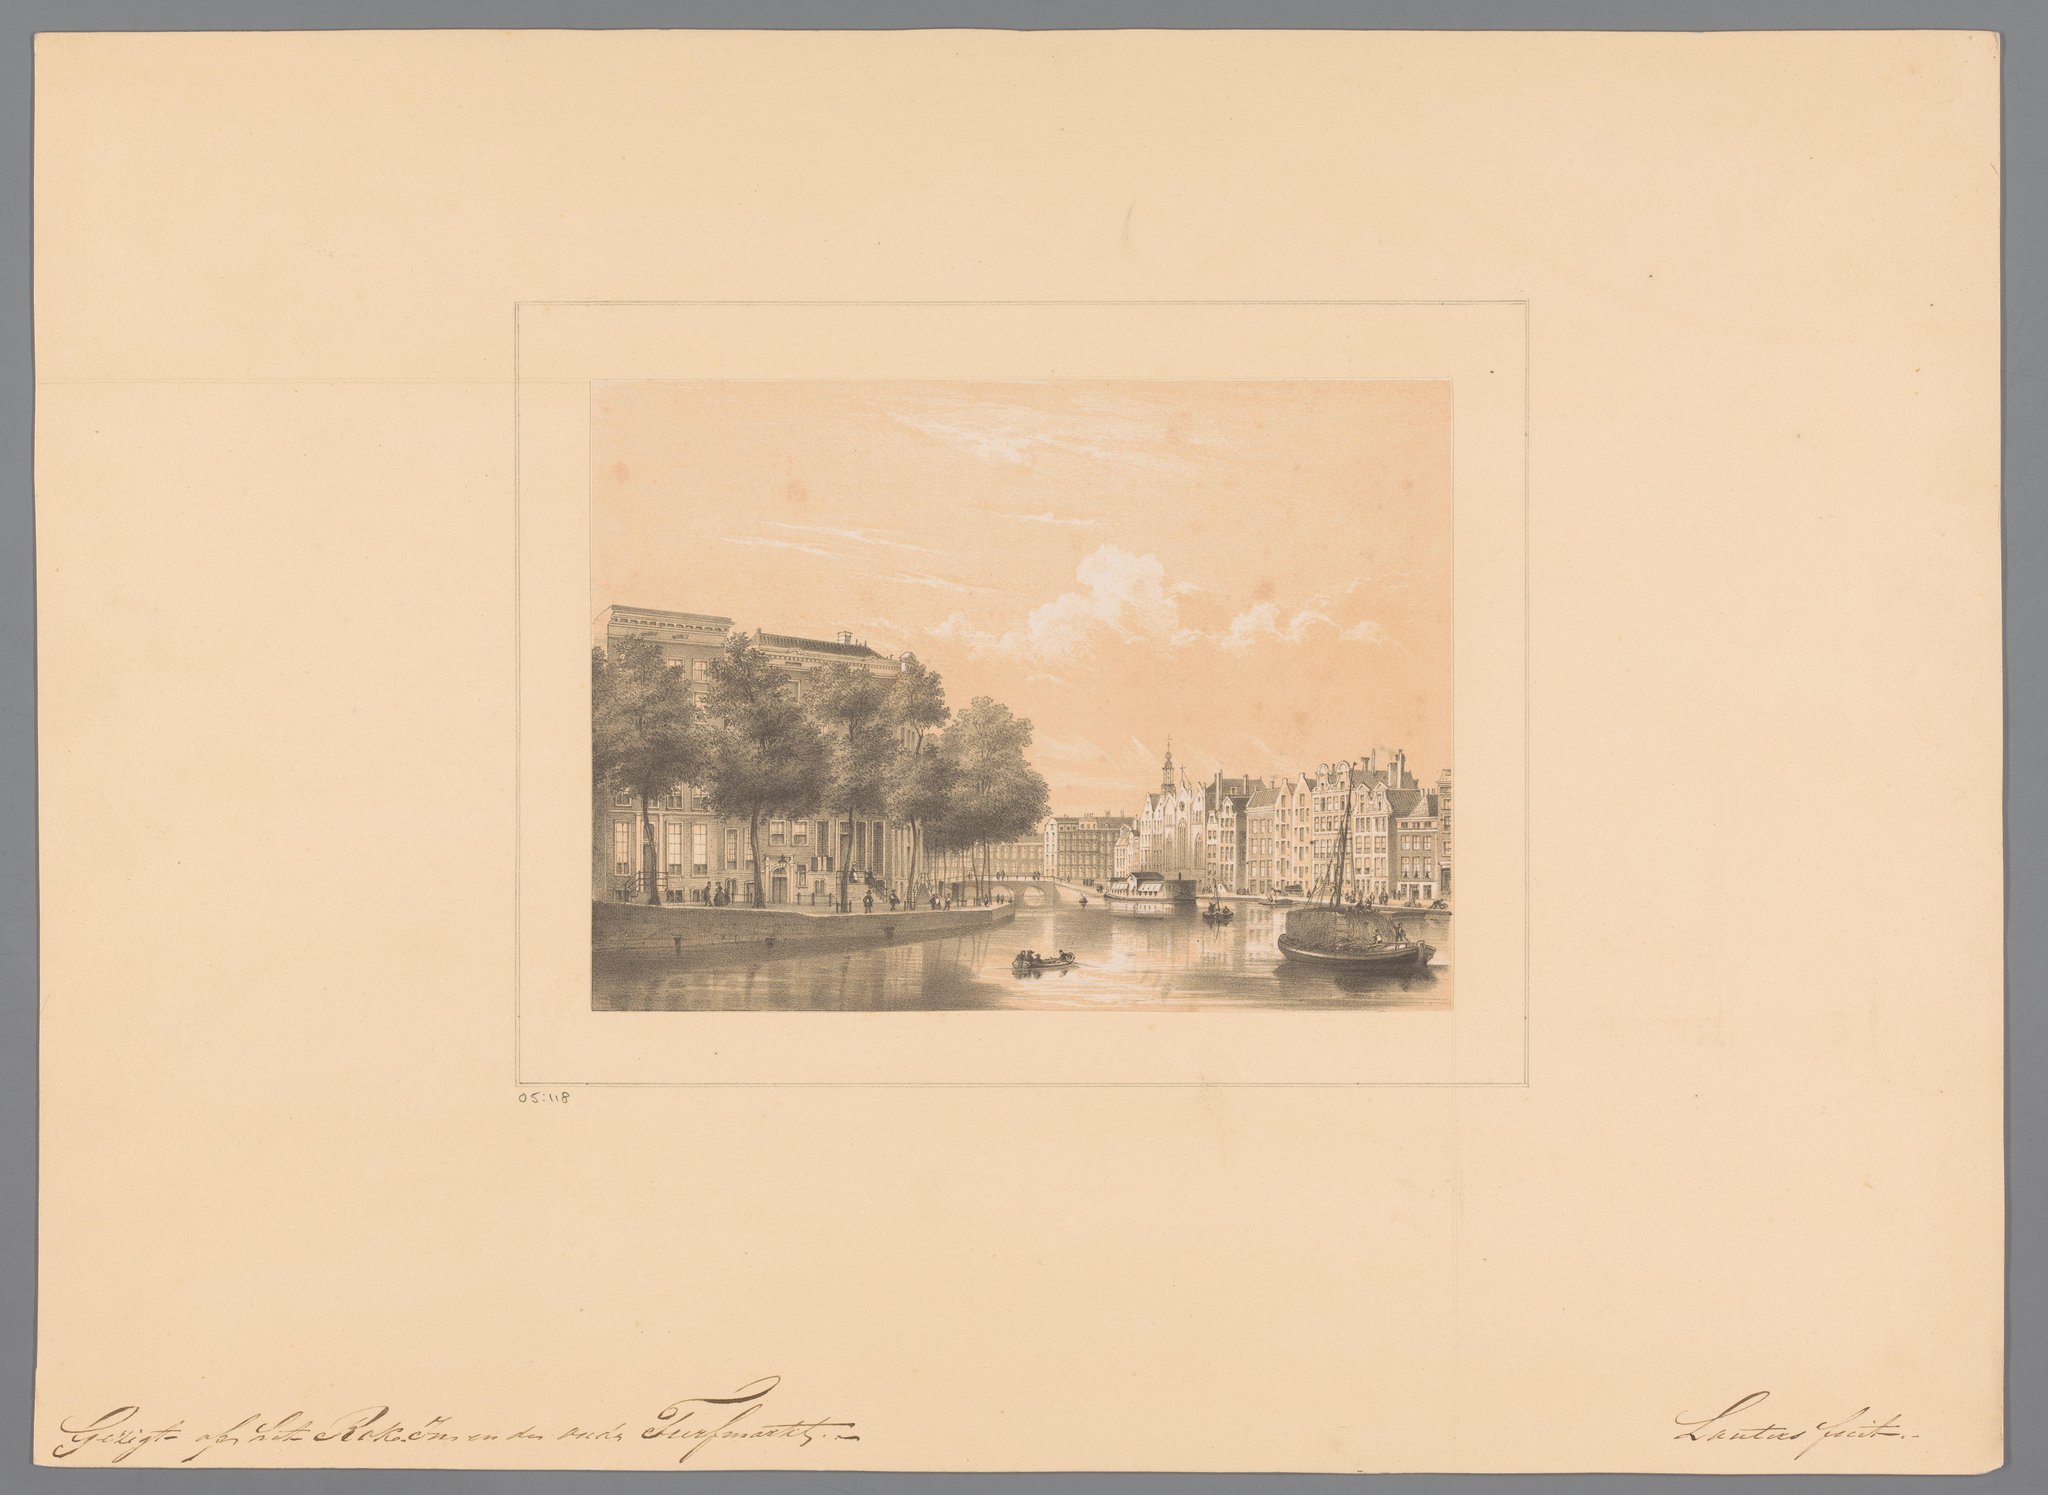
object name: print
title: Gezicht op het Rokin en de Oude Turfmarkt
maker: paulus lauters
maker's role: print maker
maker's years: 1806-1875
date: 1816-1875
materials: paper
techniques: tone lithography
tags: city-view in general; 'veduta'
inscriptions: : ‘Nederlandsche Bank’, collector's mark: Lugt 2228, annotation: ‘Gezigt op het Rok-In en den oude Turfmarkt./ Lauters fecit’